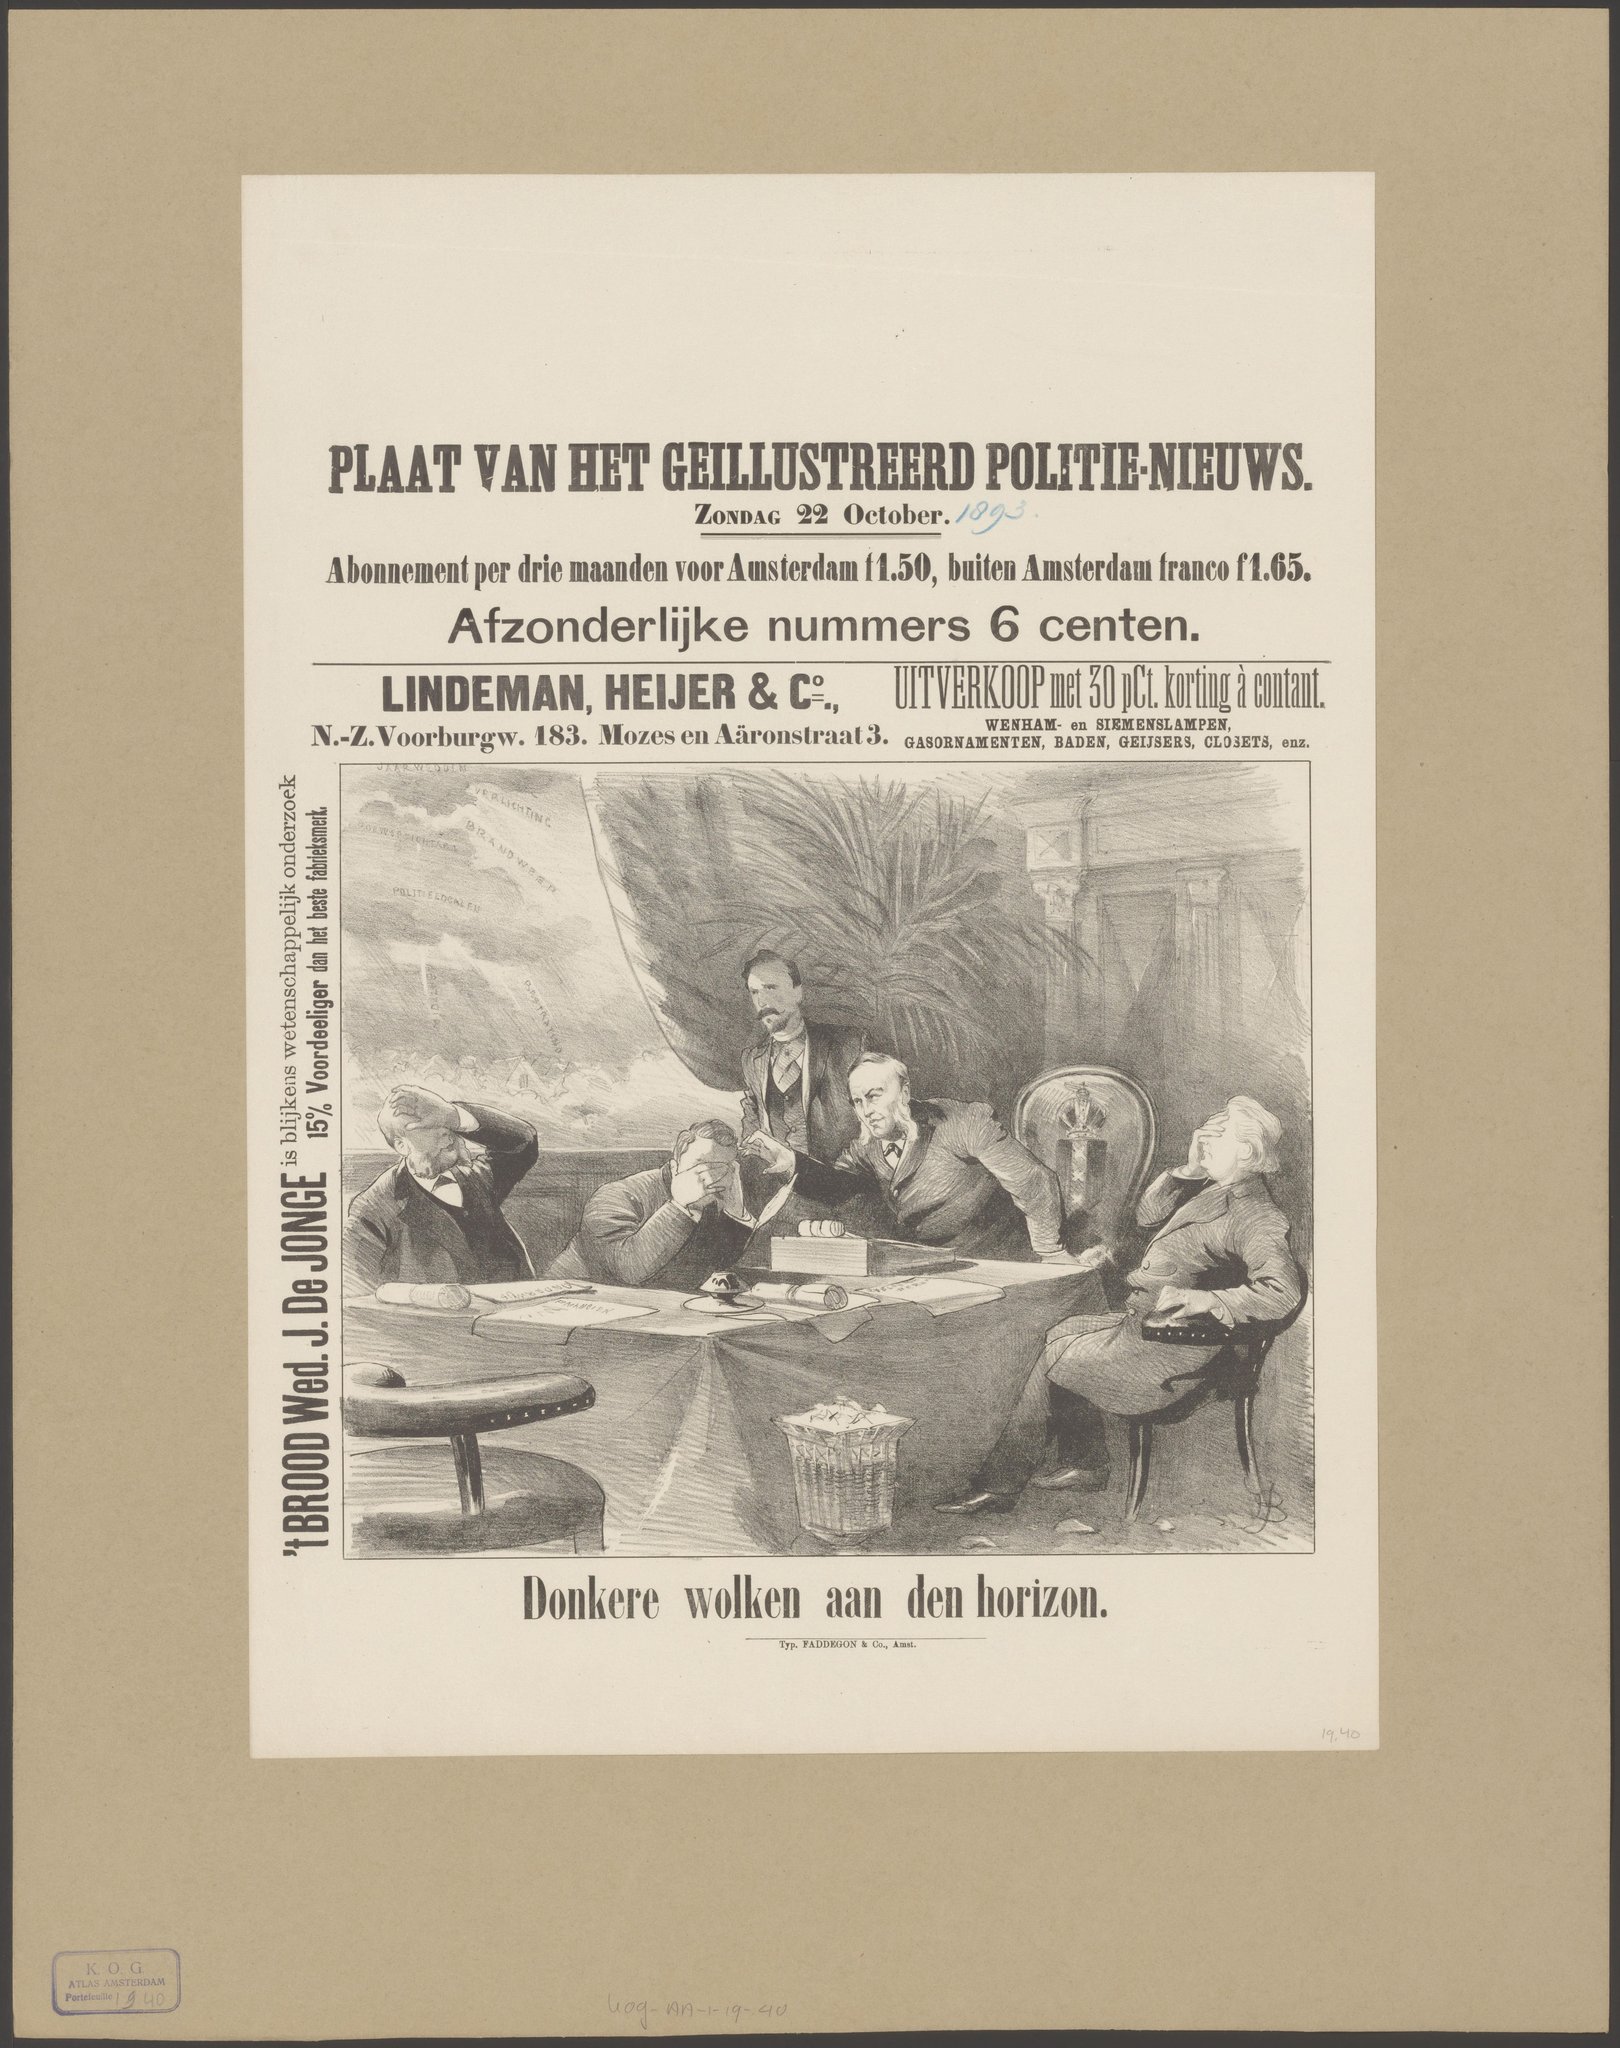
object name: cartoon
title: Spotprent op de gemeentelijke bezuinigingen van 1893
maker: johan braakensiek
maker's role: draughtsman, print maker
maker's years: 1858-1940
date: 1893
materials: paper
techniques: letterpress printing, lithograph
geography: amsterdam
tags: city council, political caricatures and satires, amsterdam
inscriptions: collector's mark: ‘19,40’ Lugt 1641b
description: Onderwerpsrubriek binnen de Atlas Amsterdam: Herinneringen aan regeringsleden en hunne huisgezinnen [na 1800].